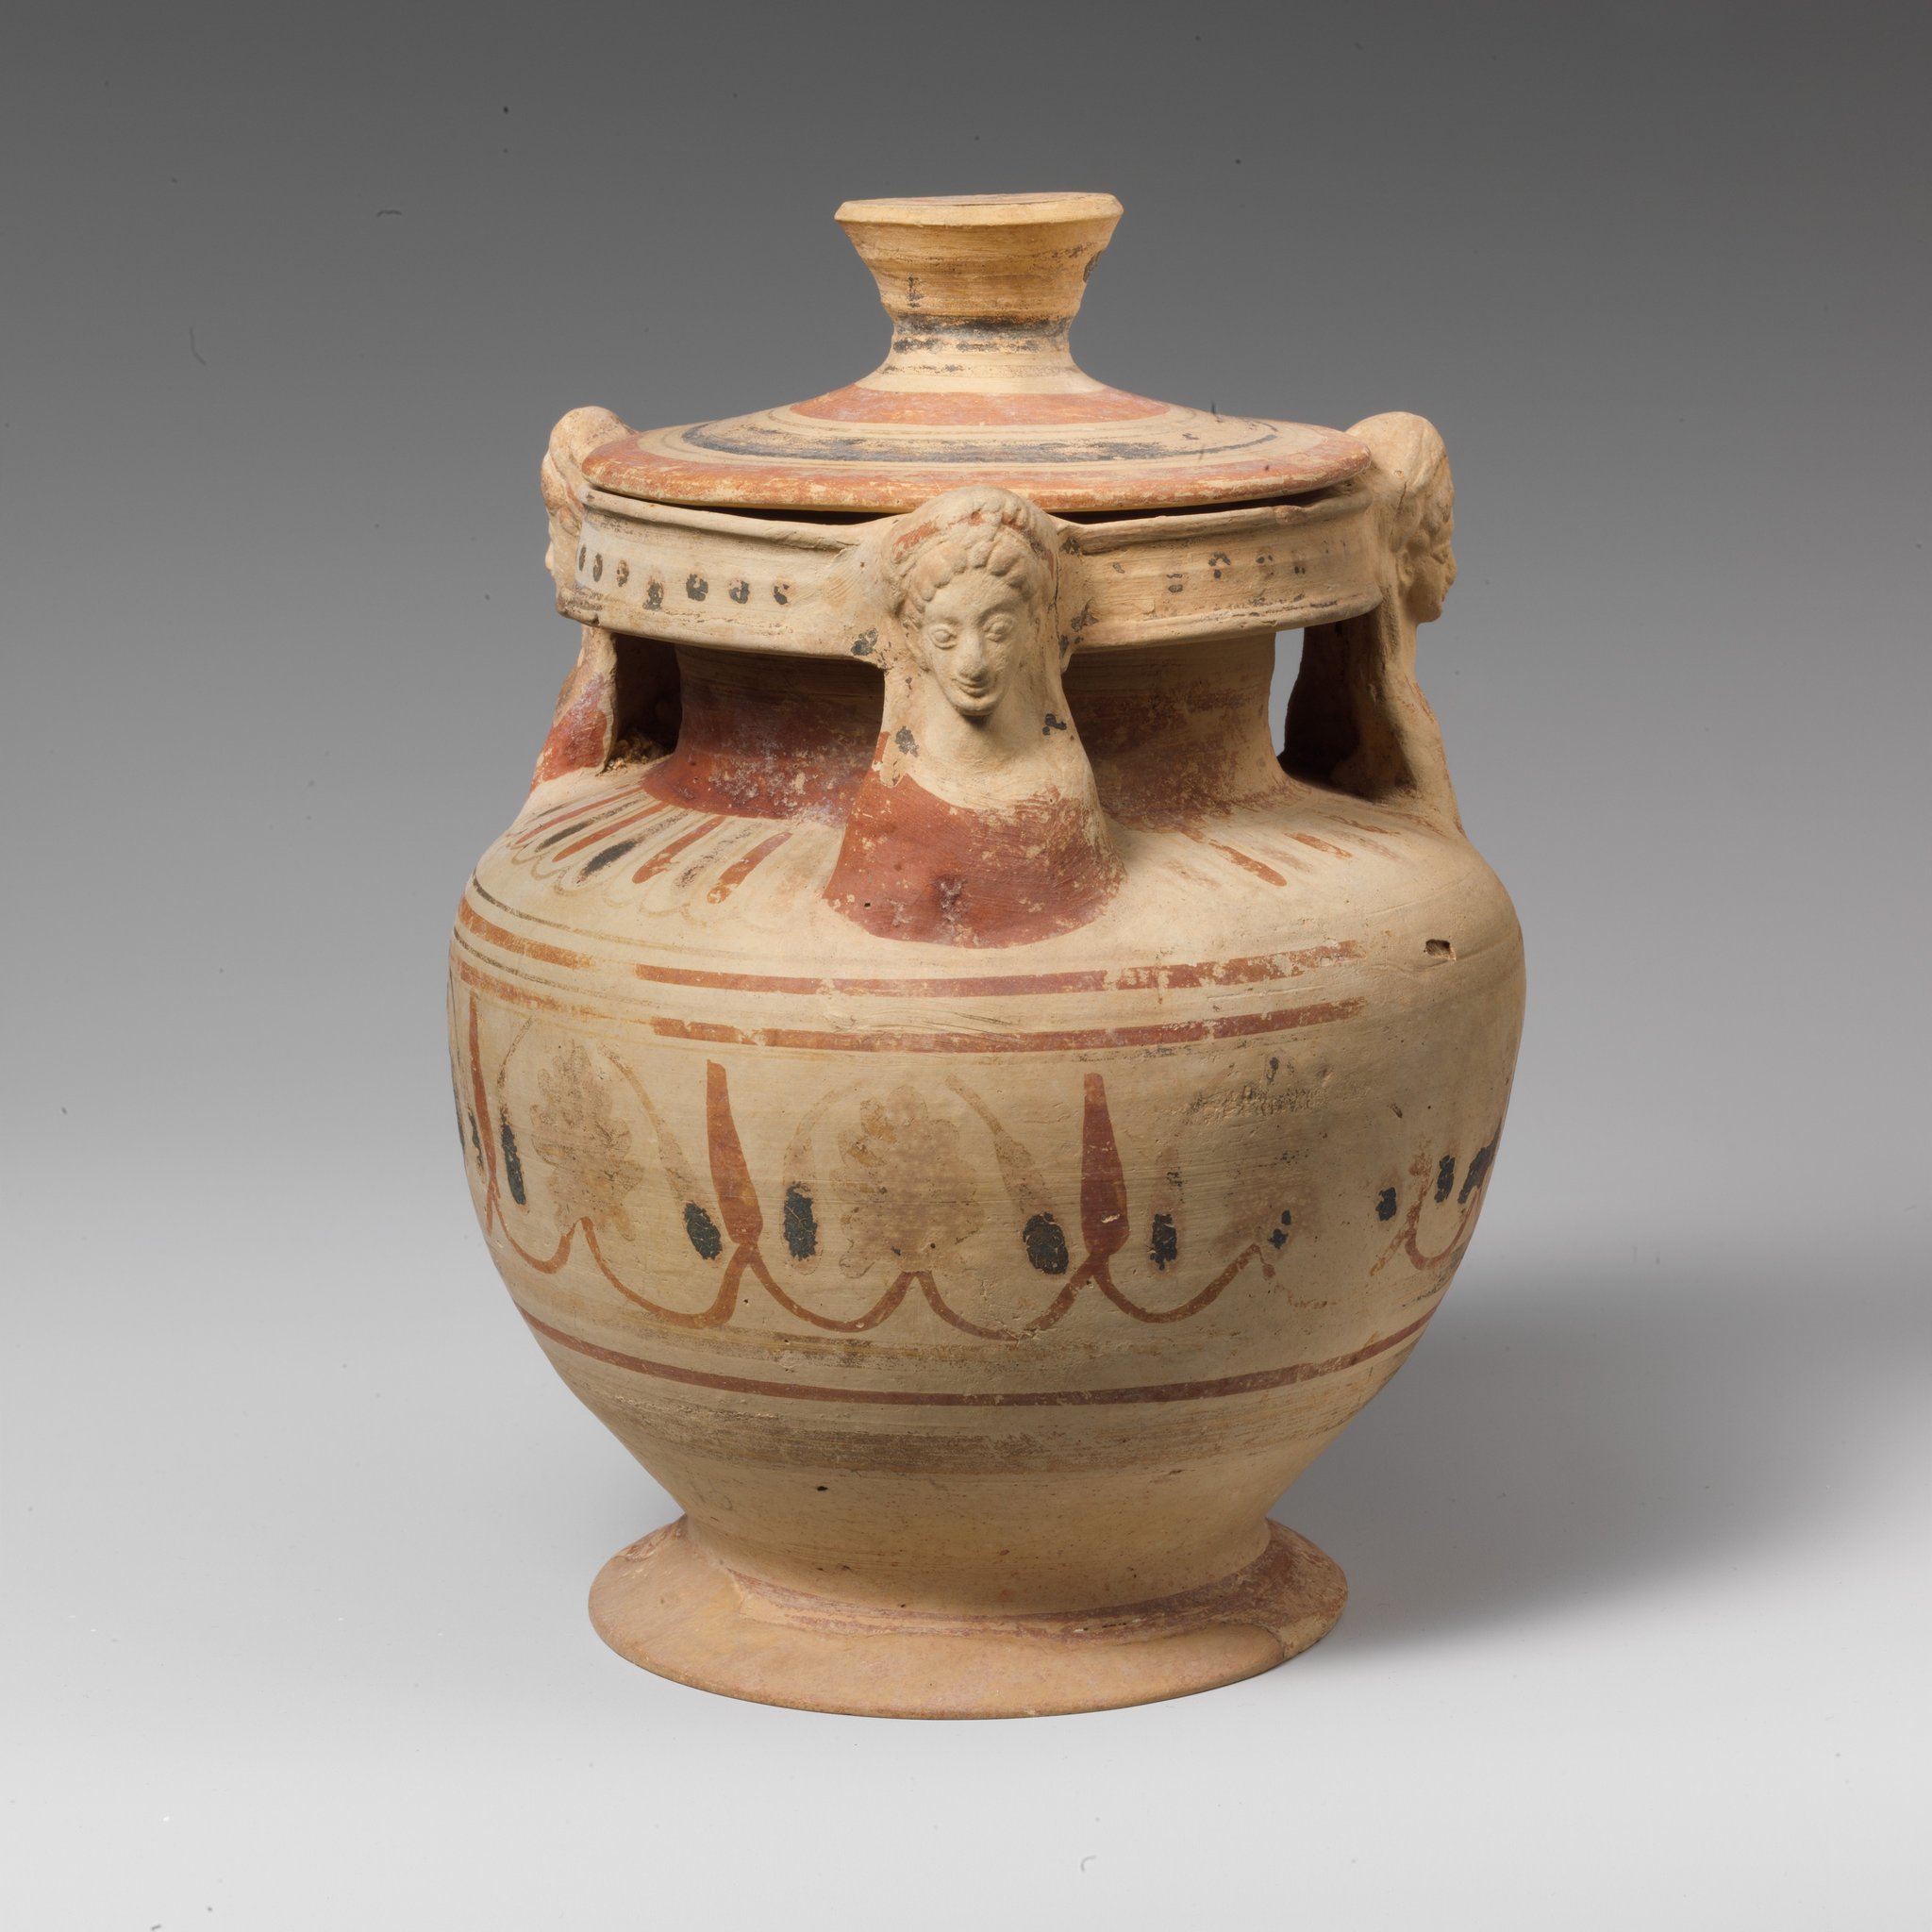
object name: pyxis with lid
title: Terracotta pyxis with lid (box)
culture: greek, corinthian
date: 534-501 BCE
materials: terracotta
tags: heads,women